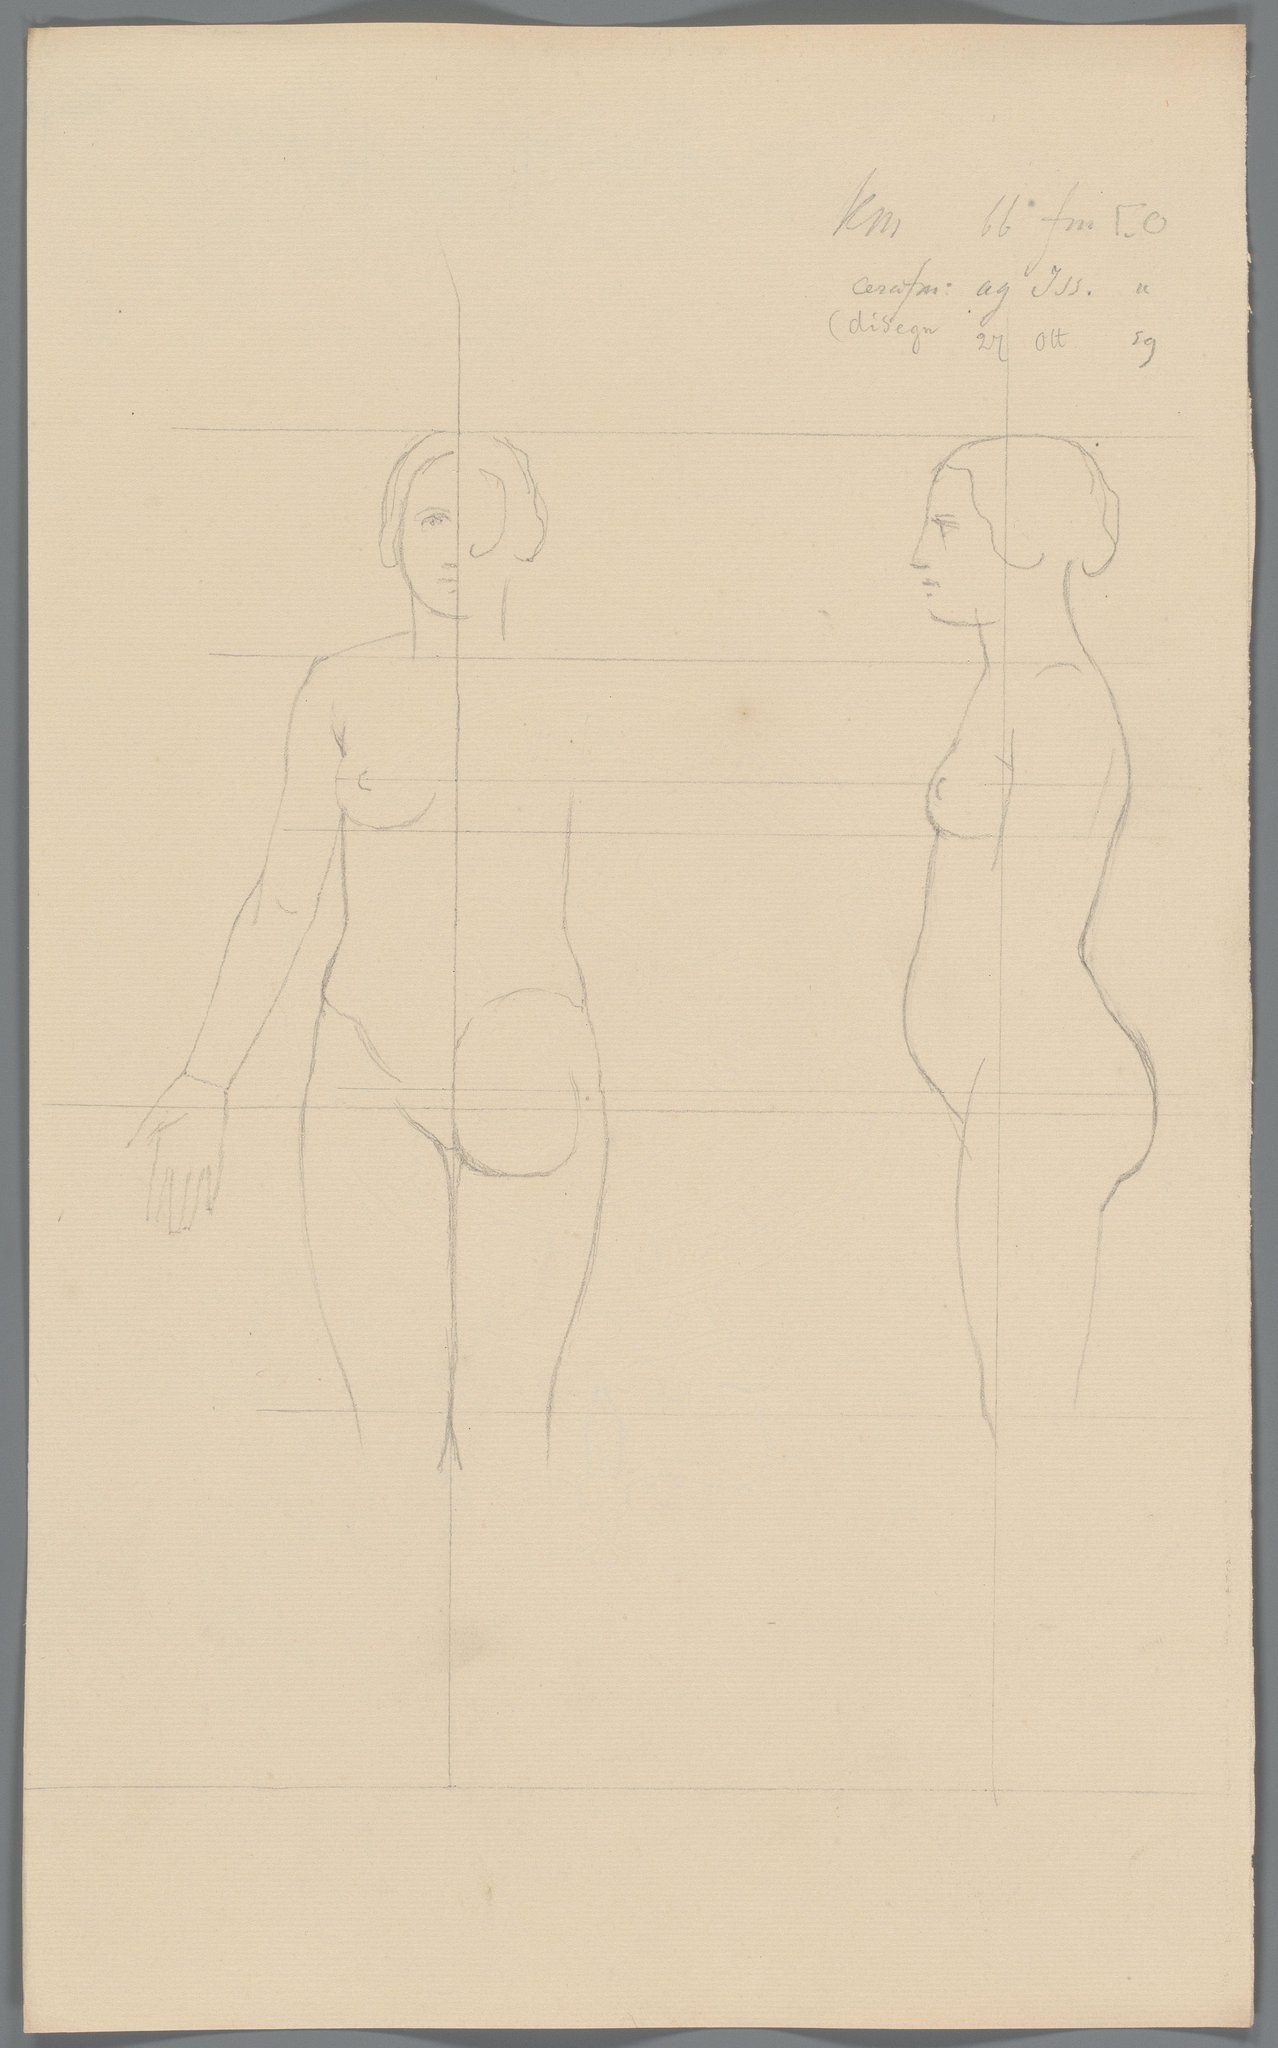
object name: drawing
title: Proportiestudie van een vrouw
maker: jacobus everhardus josephus van den berg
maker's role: draughtsman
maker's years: 1802-1861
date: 1859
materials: paper, pencil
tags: standing figure (canon, proportions) - aa - female human figure, the (nude) human figure; 'corpo humano' (ripa) - aa - female human figure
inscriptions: inscription: ‘Km 66 fm [...]/ cerafm ag Jii E)/ disegn 27 ott 59’